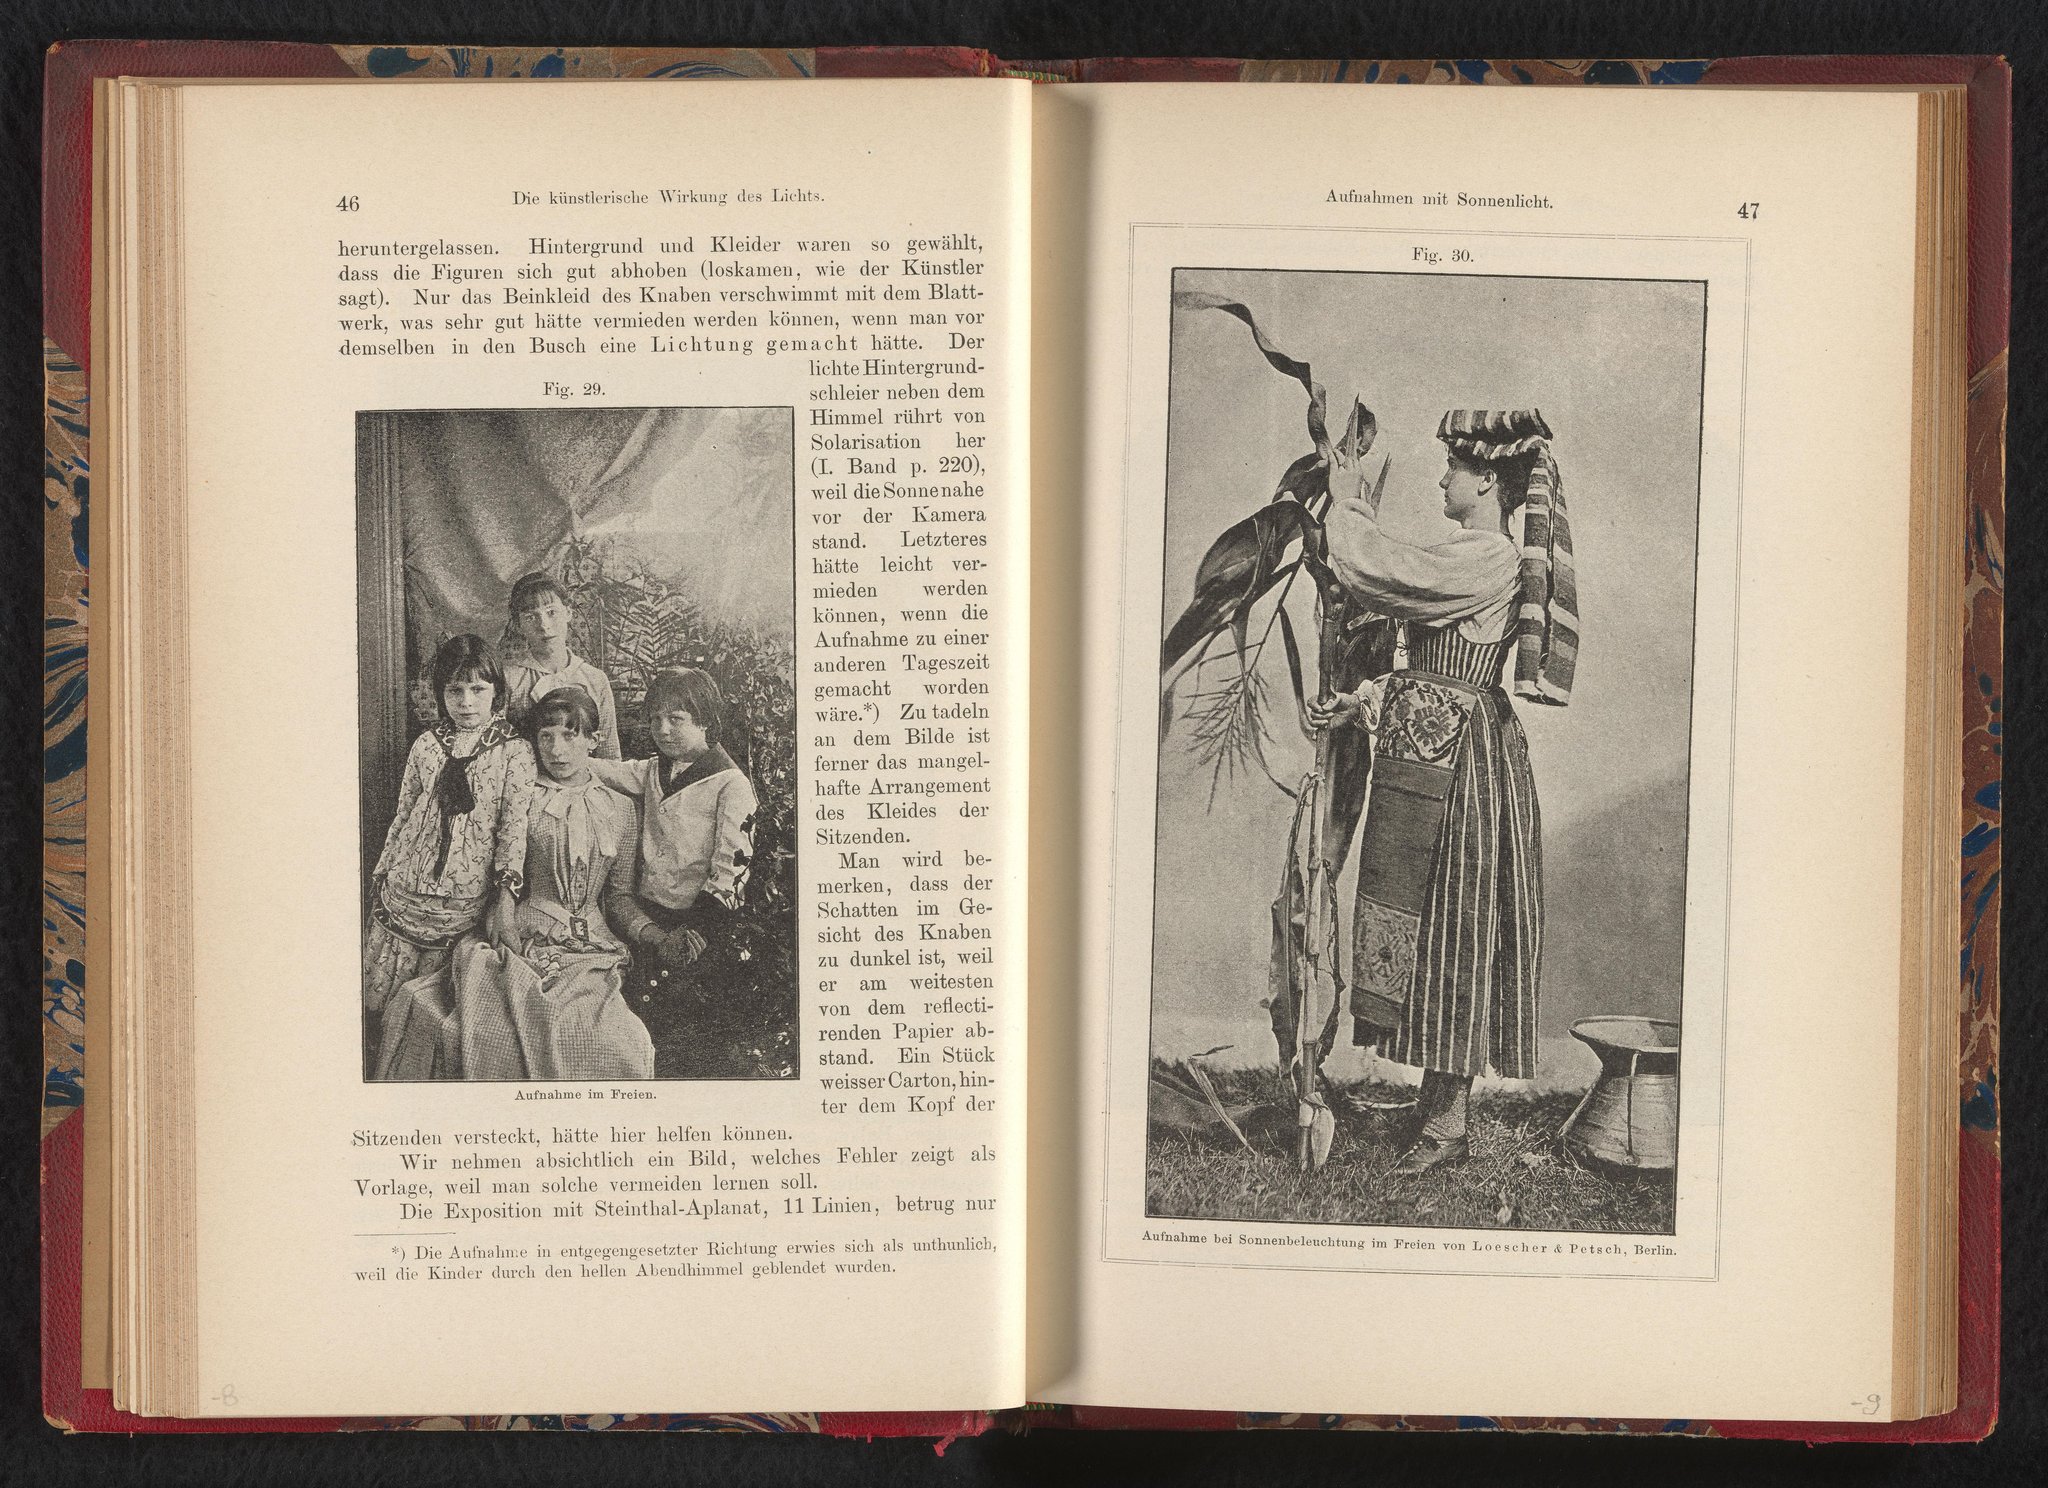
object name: photomechanical print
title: Portret van een vrouw in klederdracht met een plant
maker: heinrich riffarth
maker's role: printer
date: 1886-1891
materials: paper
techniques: autotype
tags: anonymous historical person portrayed alone - bb - woman, folk costume, regional costume, plants and herbs